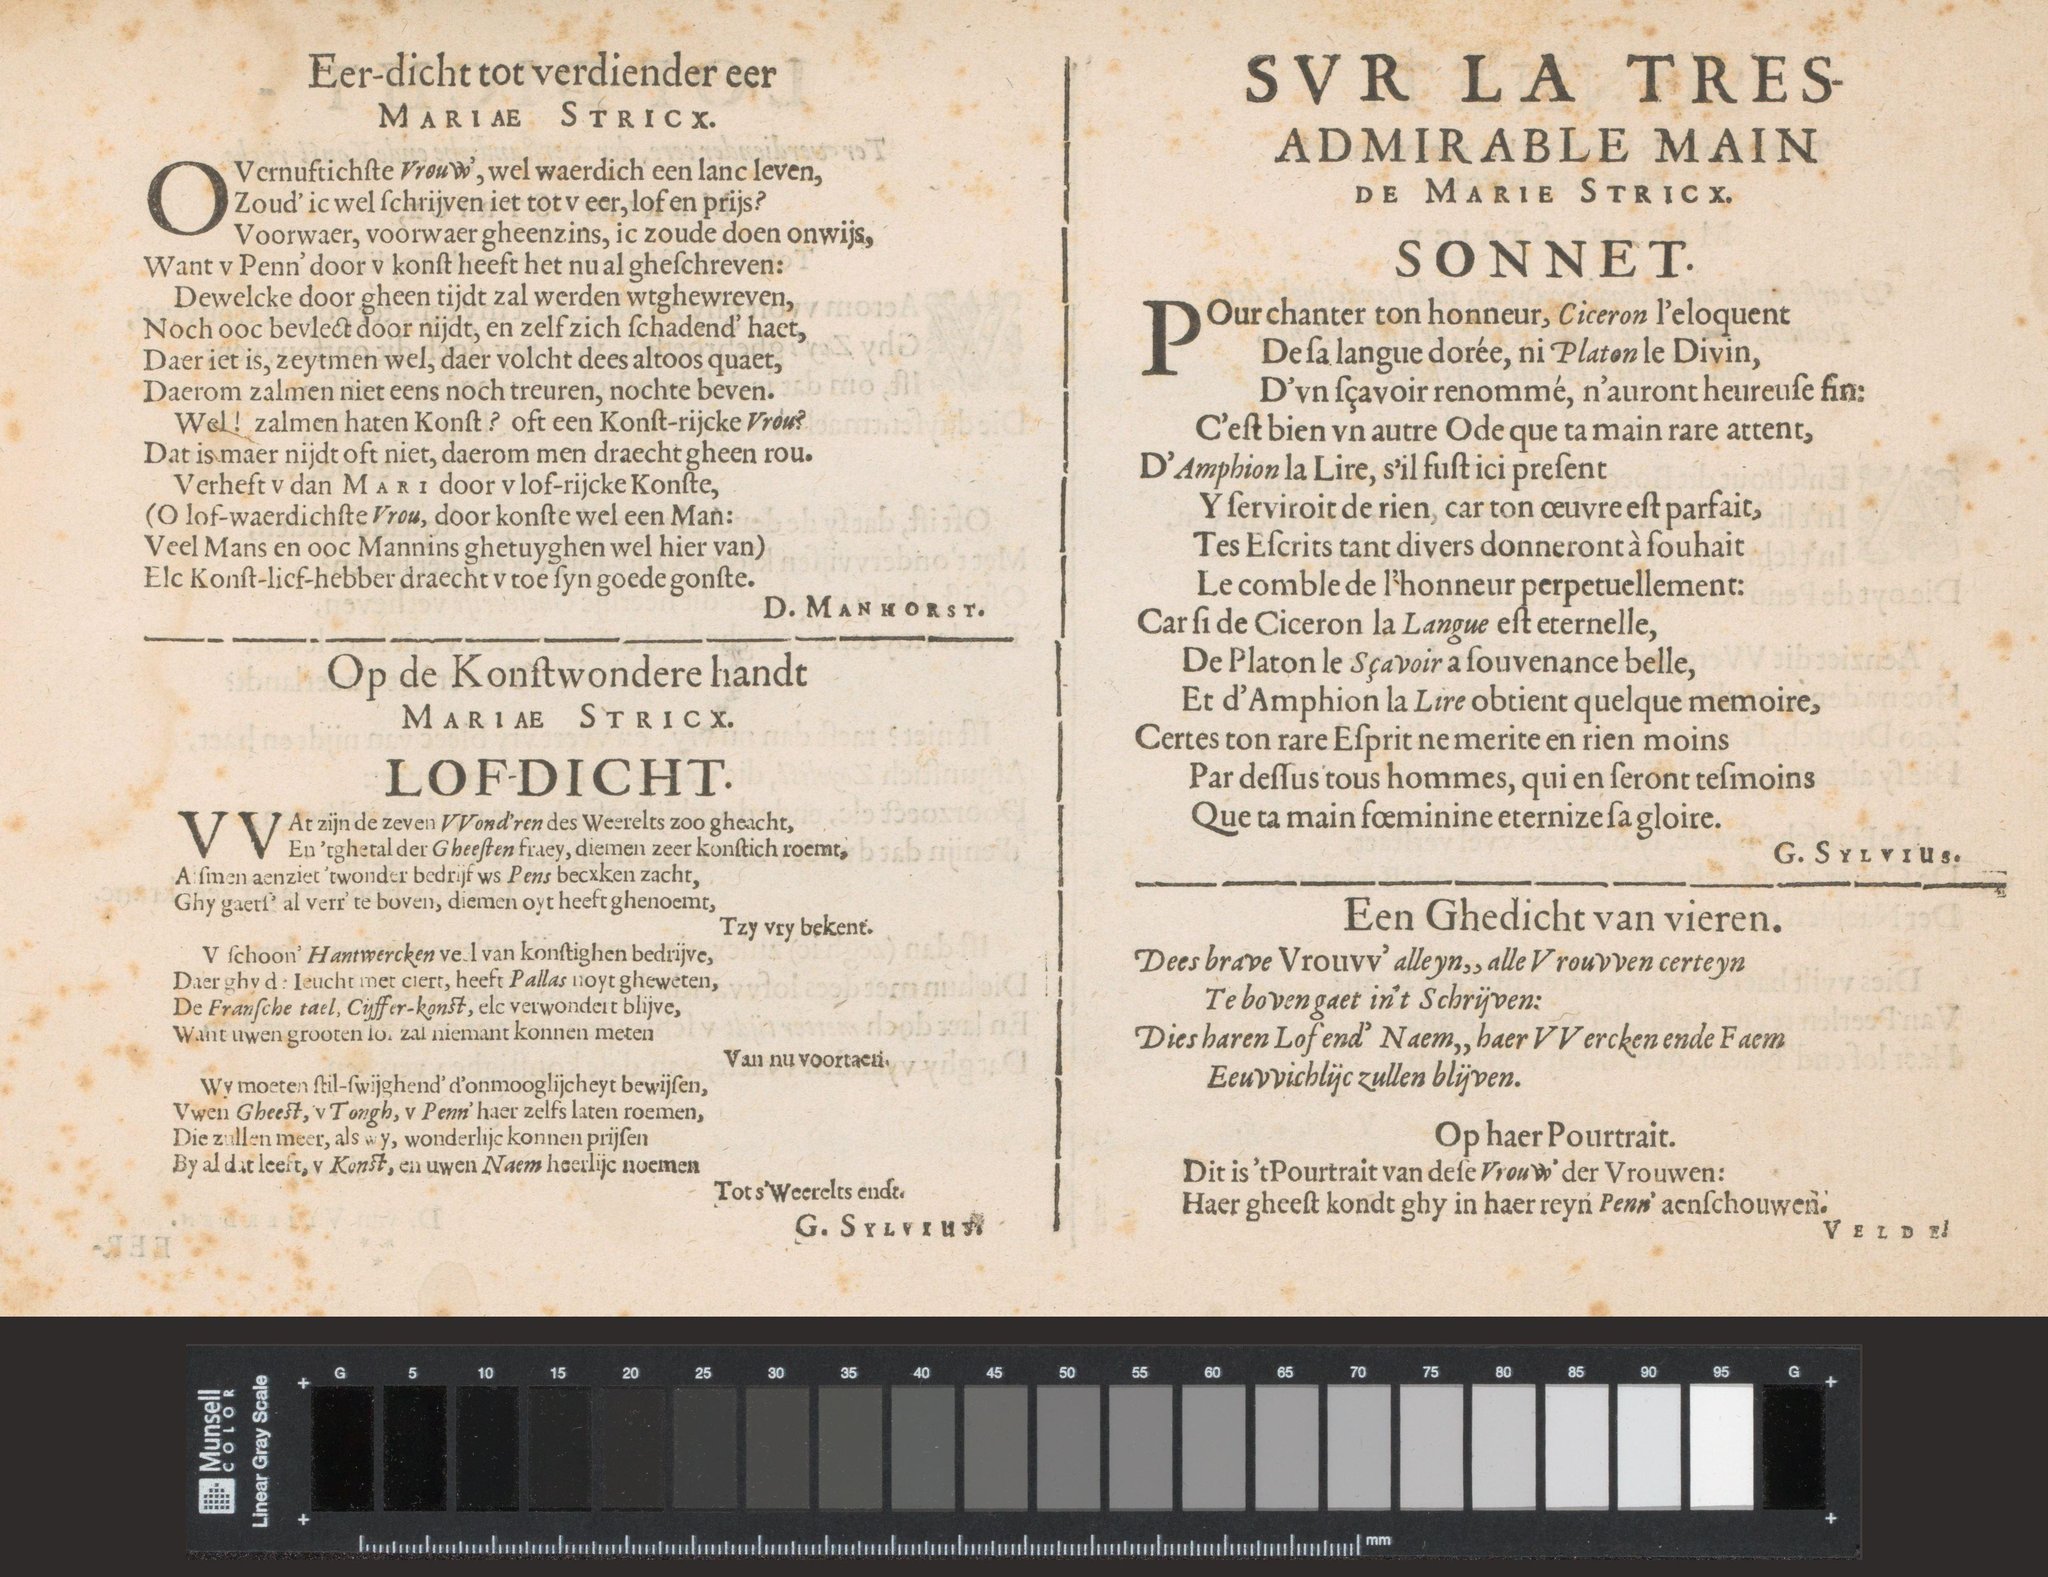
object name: album leaf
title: Schat oft voorbeelt ende verthooninge van verscheyden geschriften (...)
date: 1618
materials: paper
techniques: letterpress printing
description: Vier drempeldichten van drie auteurs als inleiding bij een serie kalligrafische schrijfvoorbeelden van Maria Strick, drie in het Nederlands en een in het Frans. Het blad maakt deel uit van een album.